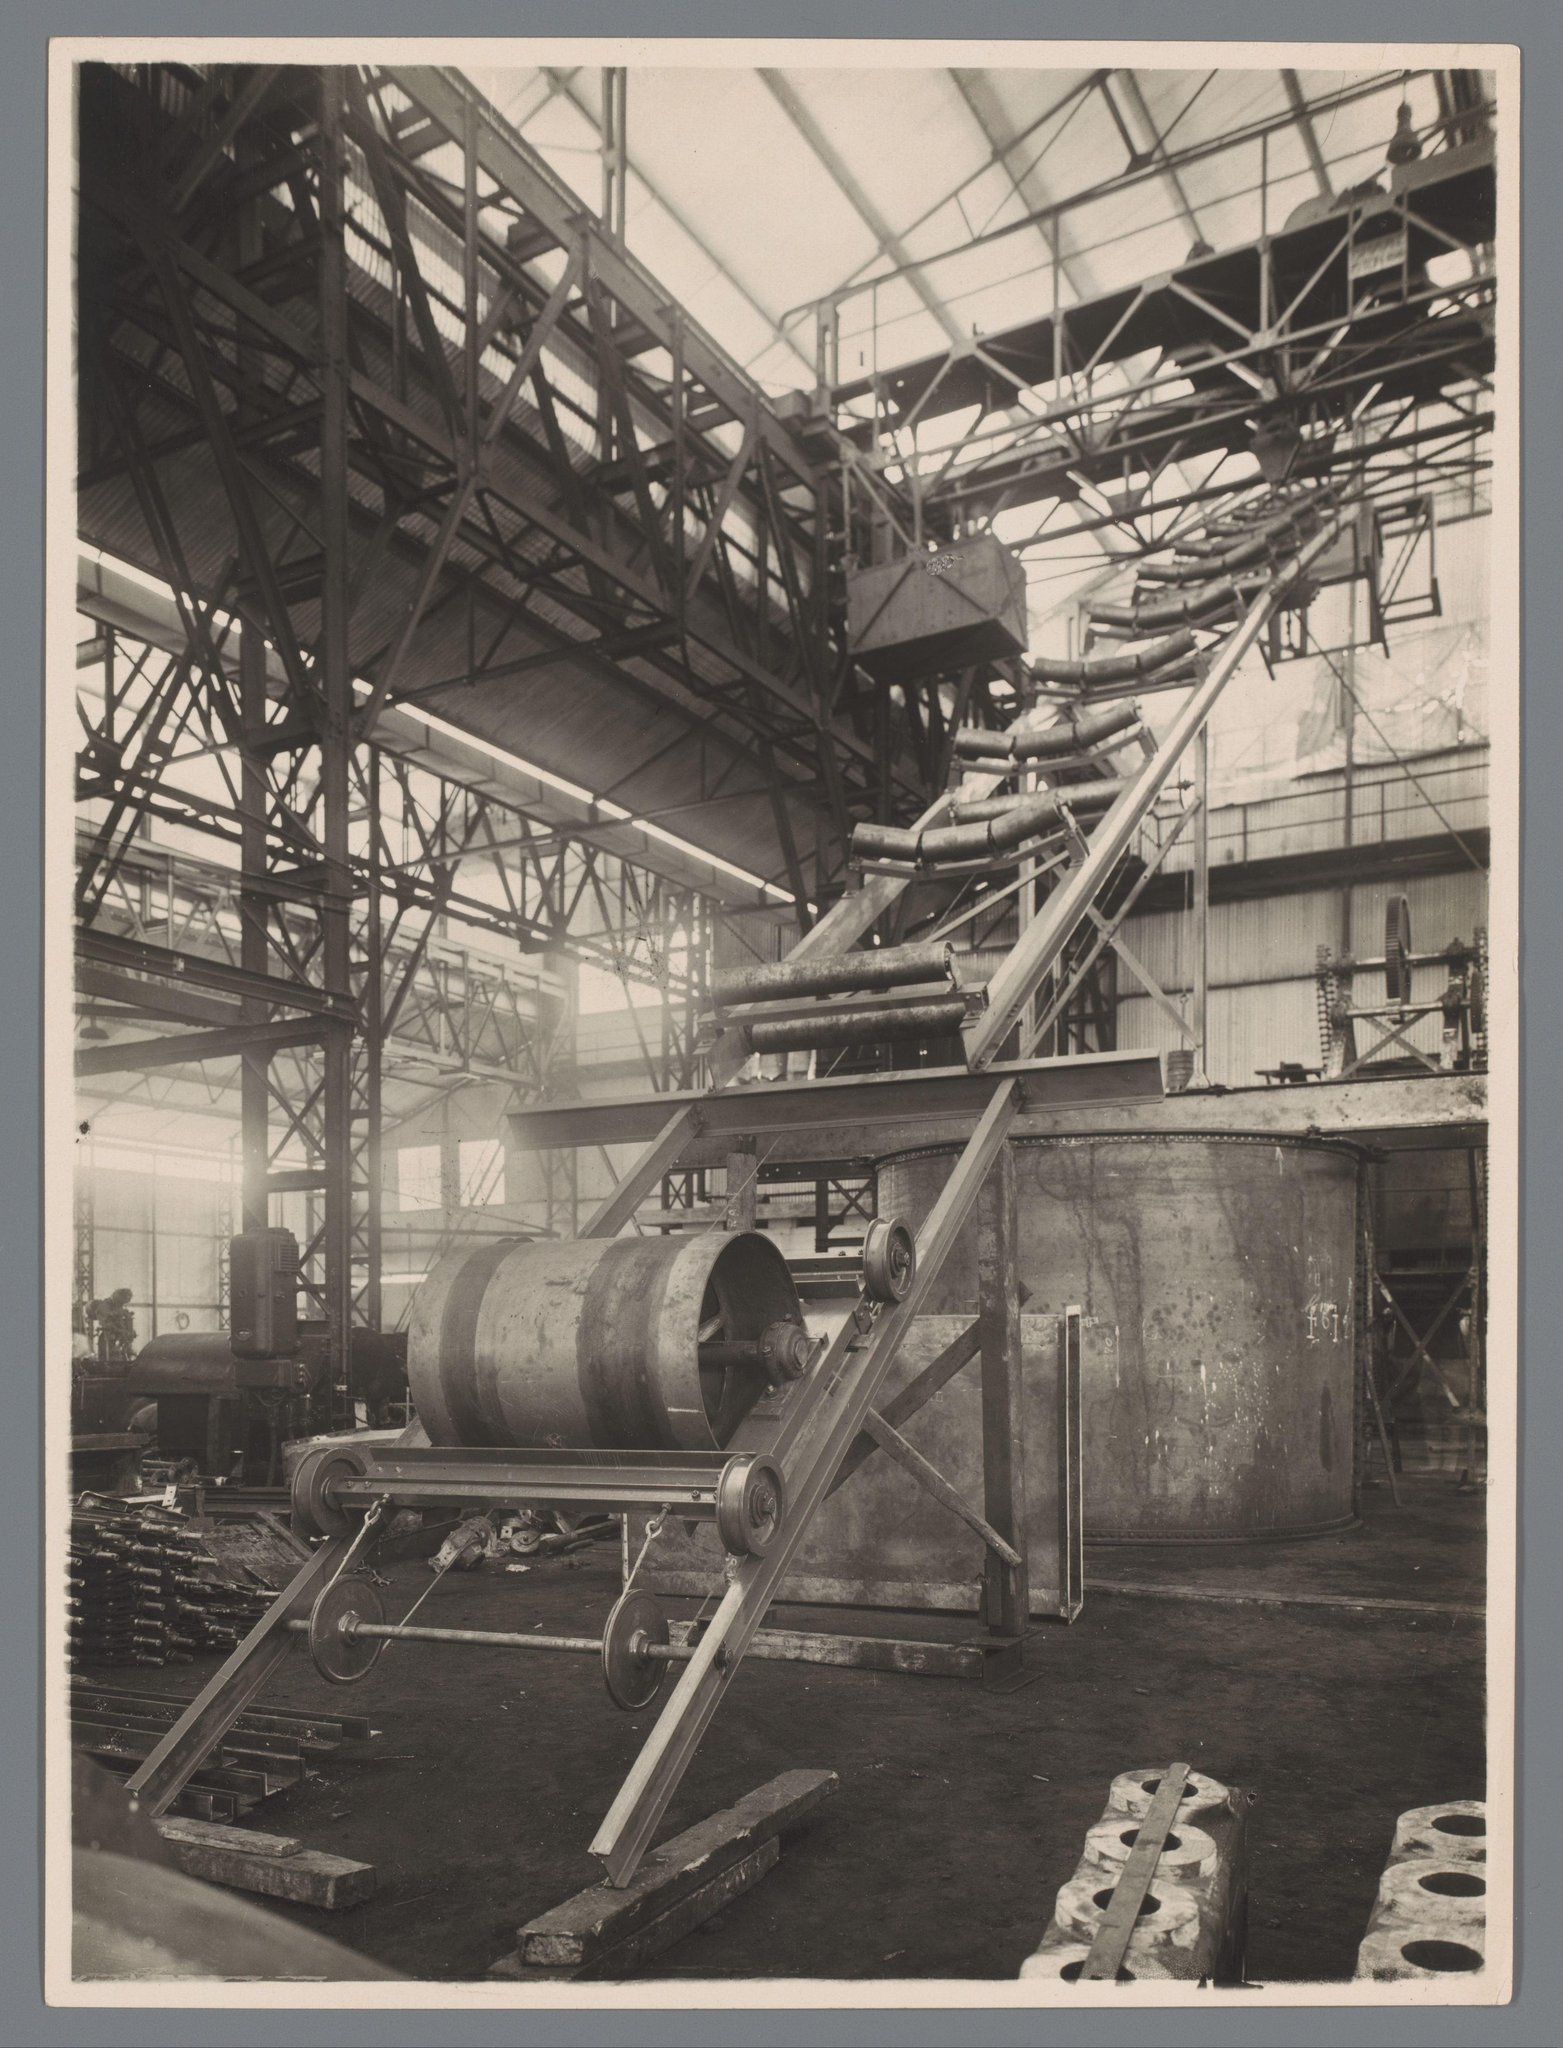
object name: photograph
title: Natblad transporteur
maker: Anonymous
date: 1931-1937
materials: photographic support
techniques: gelatin silver print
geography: java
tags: colonial system, factory-interior, machine shop, machines; parts of machines; tools and appliances, (non-fruit) products of plants or trees (with name), tea (leaves), java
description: Transporteur van natblad op de theefabriek Pasir Randoe op Java. Onderdeel van de multomap met foto's van machines van de N.V. Machinefabriek Braat te Soerabaja en Soekaboemi bestemd voor de Nederlandse theeindustrie op Java en Sumatra, uit de periode 1931-1937.